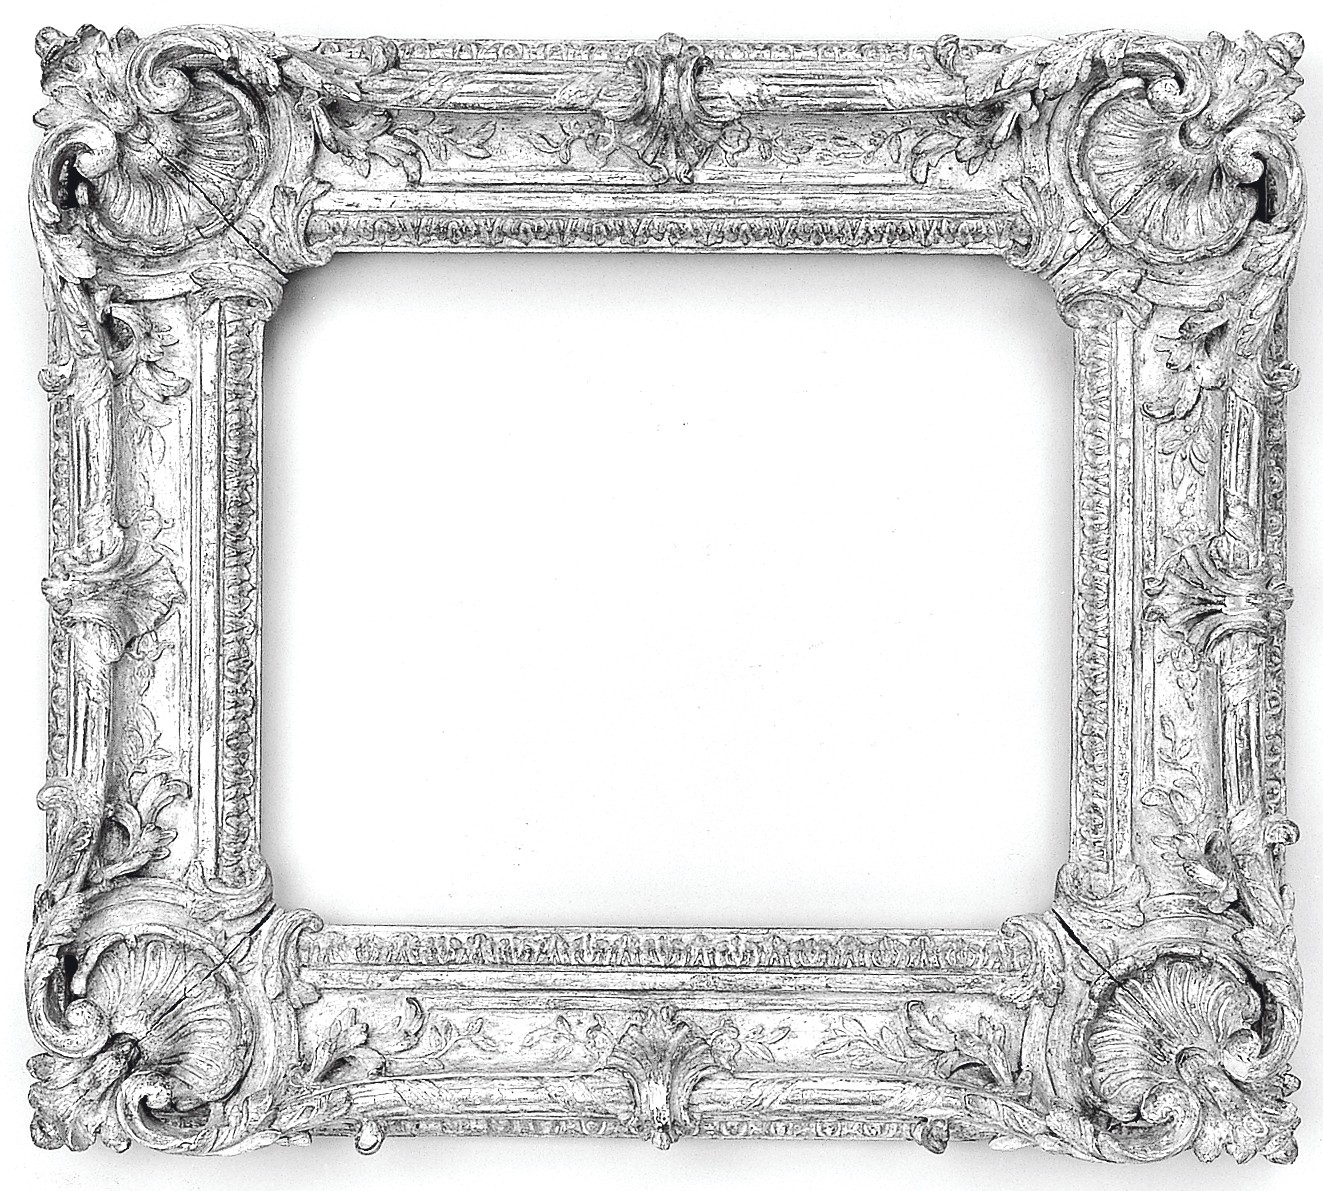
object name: frame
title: Hollow frame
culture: french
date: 1845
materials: feather, wood